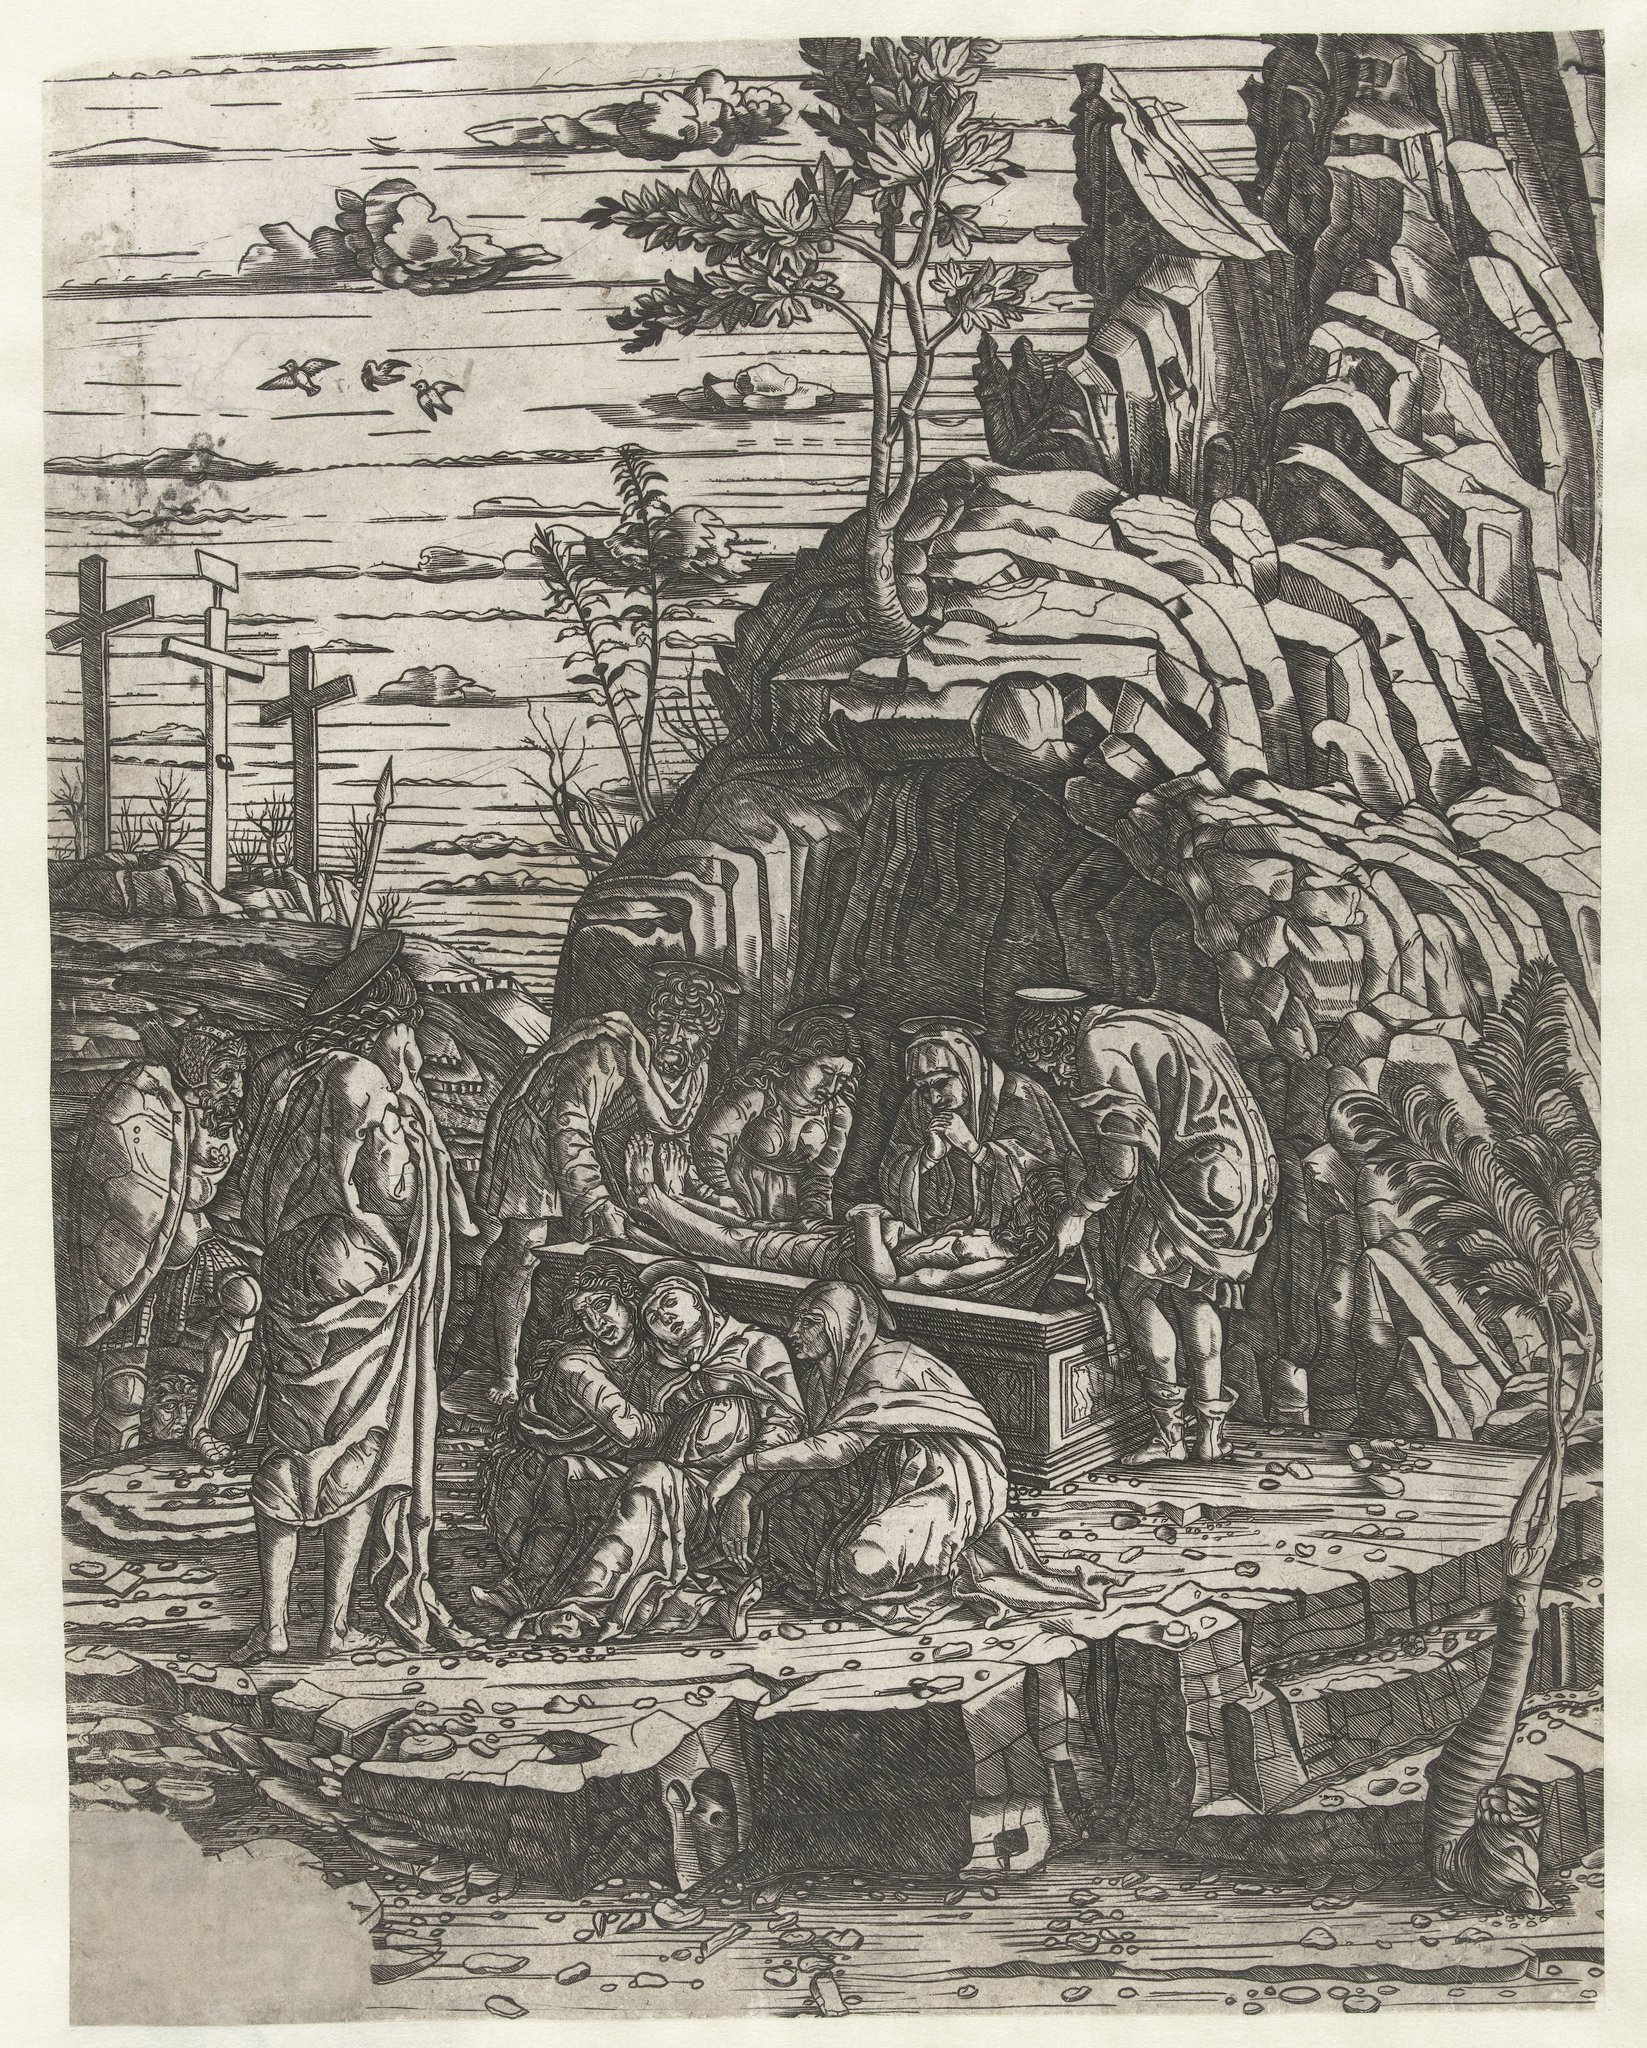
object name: print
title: Graflegging van Christus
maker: andrea mantegna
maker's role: print maker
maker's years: 1431-1506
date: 1475-1480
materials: paper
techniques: engraving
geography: italy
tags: christ's entombment (possibly by angels)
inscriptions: collector's mark: Lugt 10, inscription: ‘B 25 f 90-92’, collector's mark: ‘Hinloopen’ Lugt 11, collector's mark: Lugt 11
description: De voorstelling lijkt gebaseerd op een scène uit een Passie serie van Andrea Mantegna (zie documentatie).